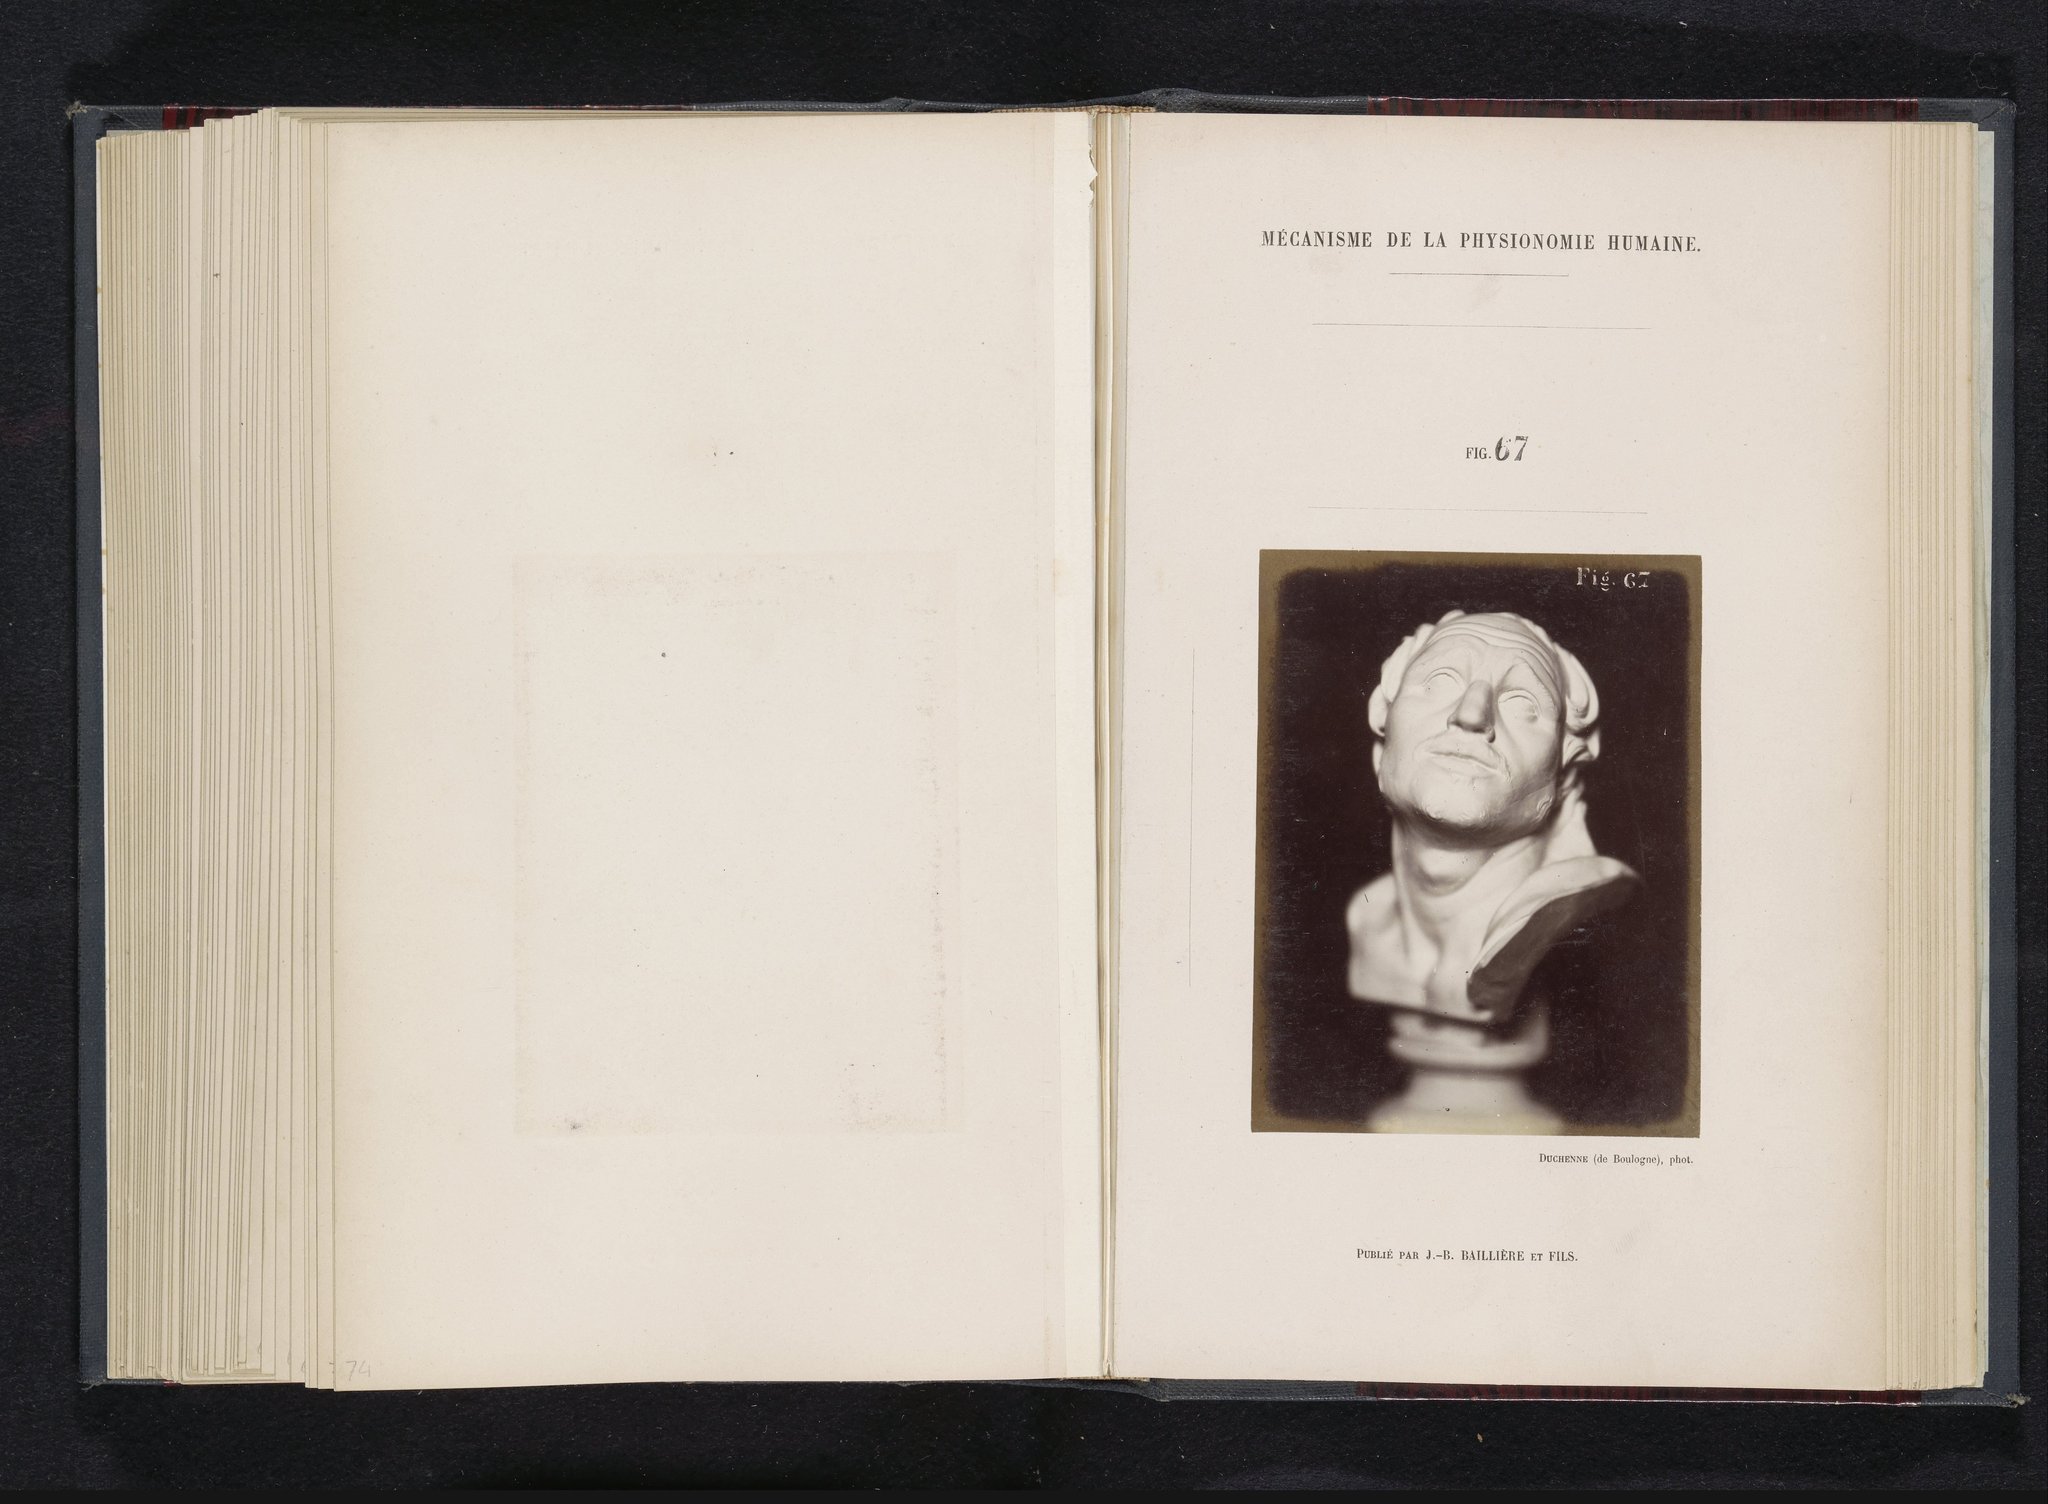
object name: photograph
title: Beeld van 'l'Arrotino'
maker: guillaume benjamin amand duchenne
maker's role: fotograaf, medicus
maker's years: 1806-1875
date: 1860-1862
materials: paper, photographic support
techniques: albumen print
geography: paris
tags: face, physiology and anatomy ~ nervous system, neurology, physiology and anatomy, morphology of facial expression, piece of sculpture, reproduction of a piece of sculpture, physiognomy, experiment, test ~ science and technology, france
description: Ongenummerde pagina met foto 67 uit Mécanisme de la physionomie humaine ou analyse électro-physiologique de l'expression des passions (Atlas).